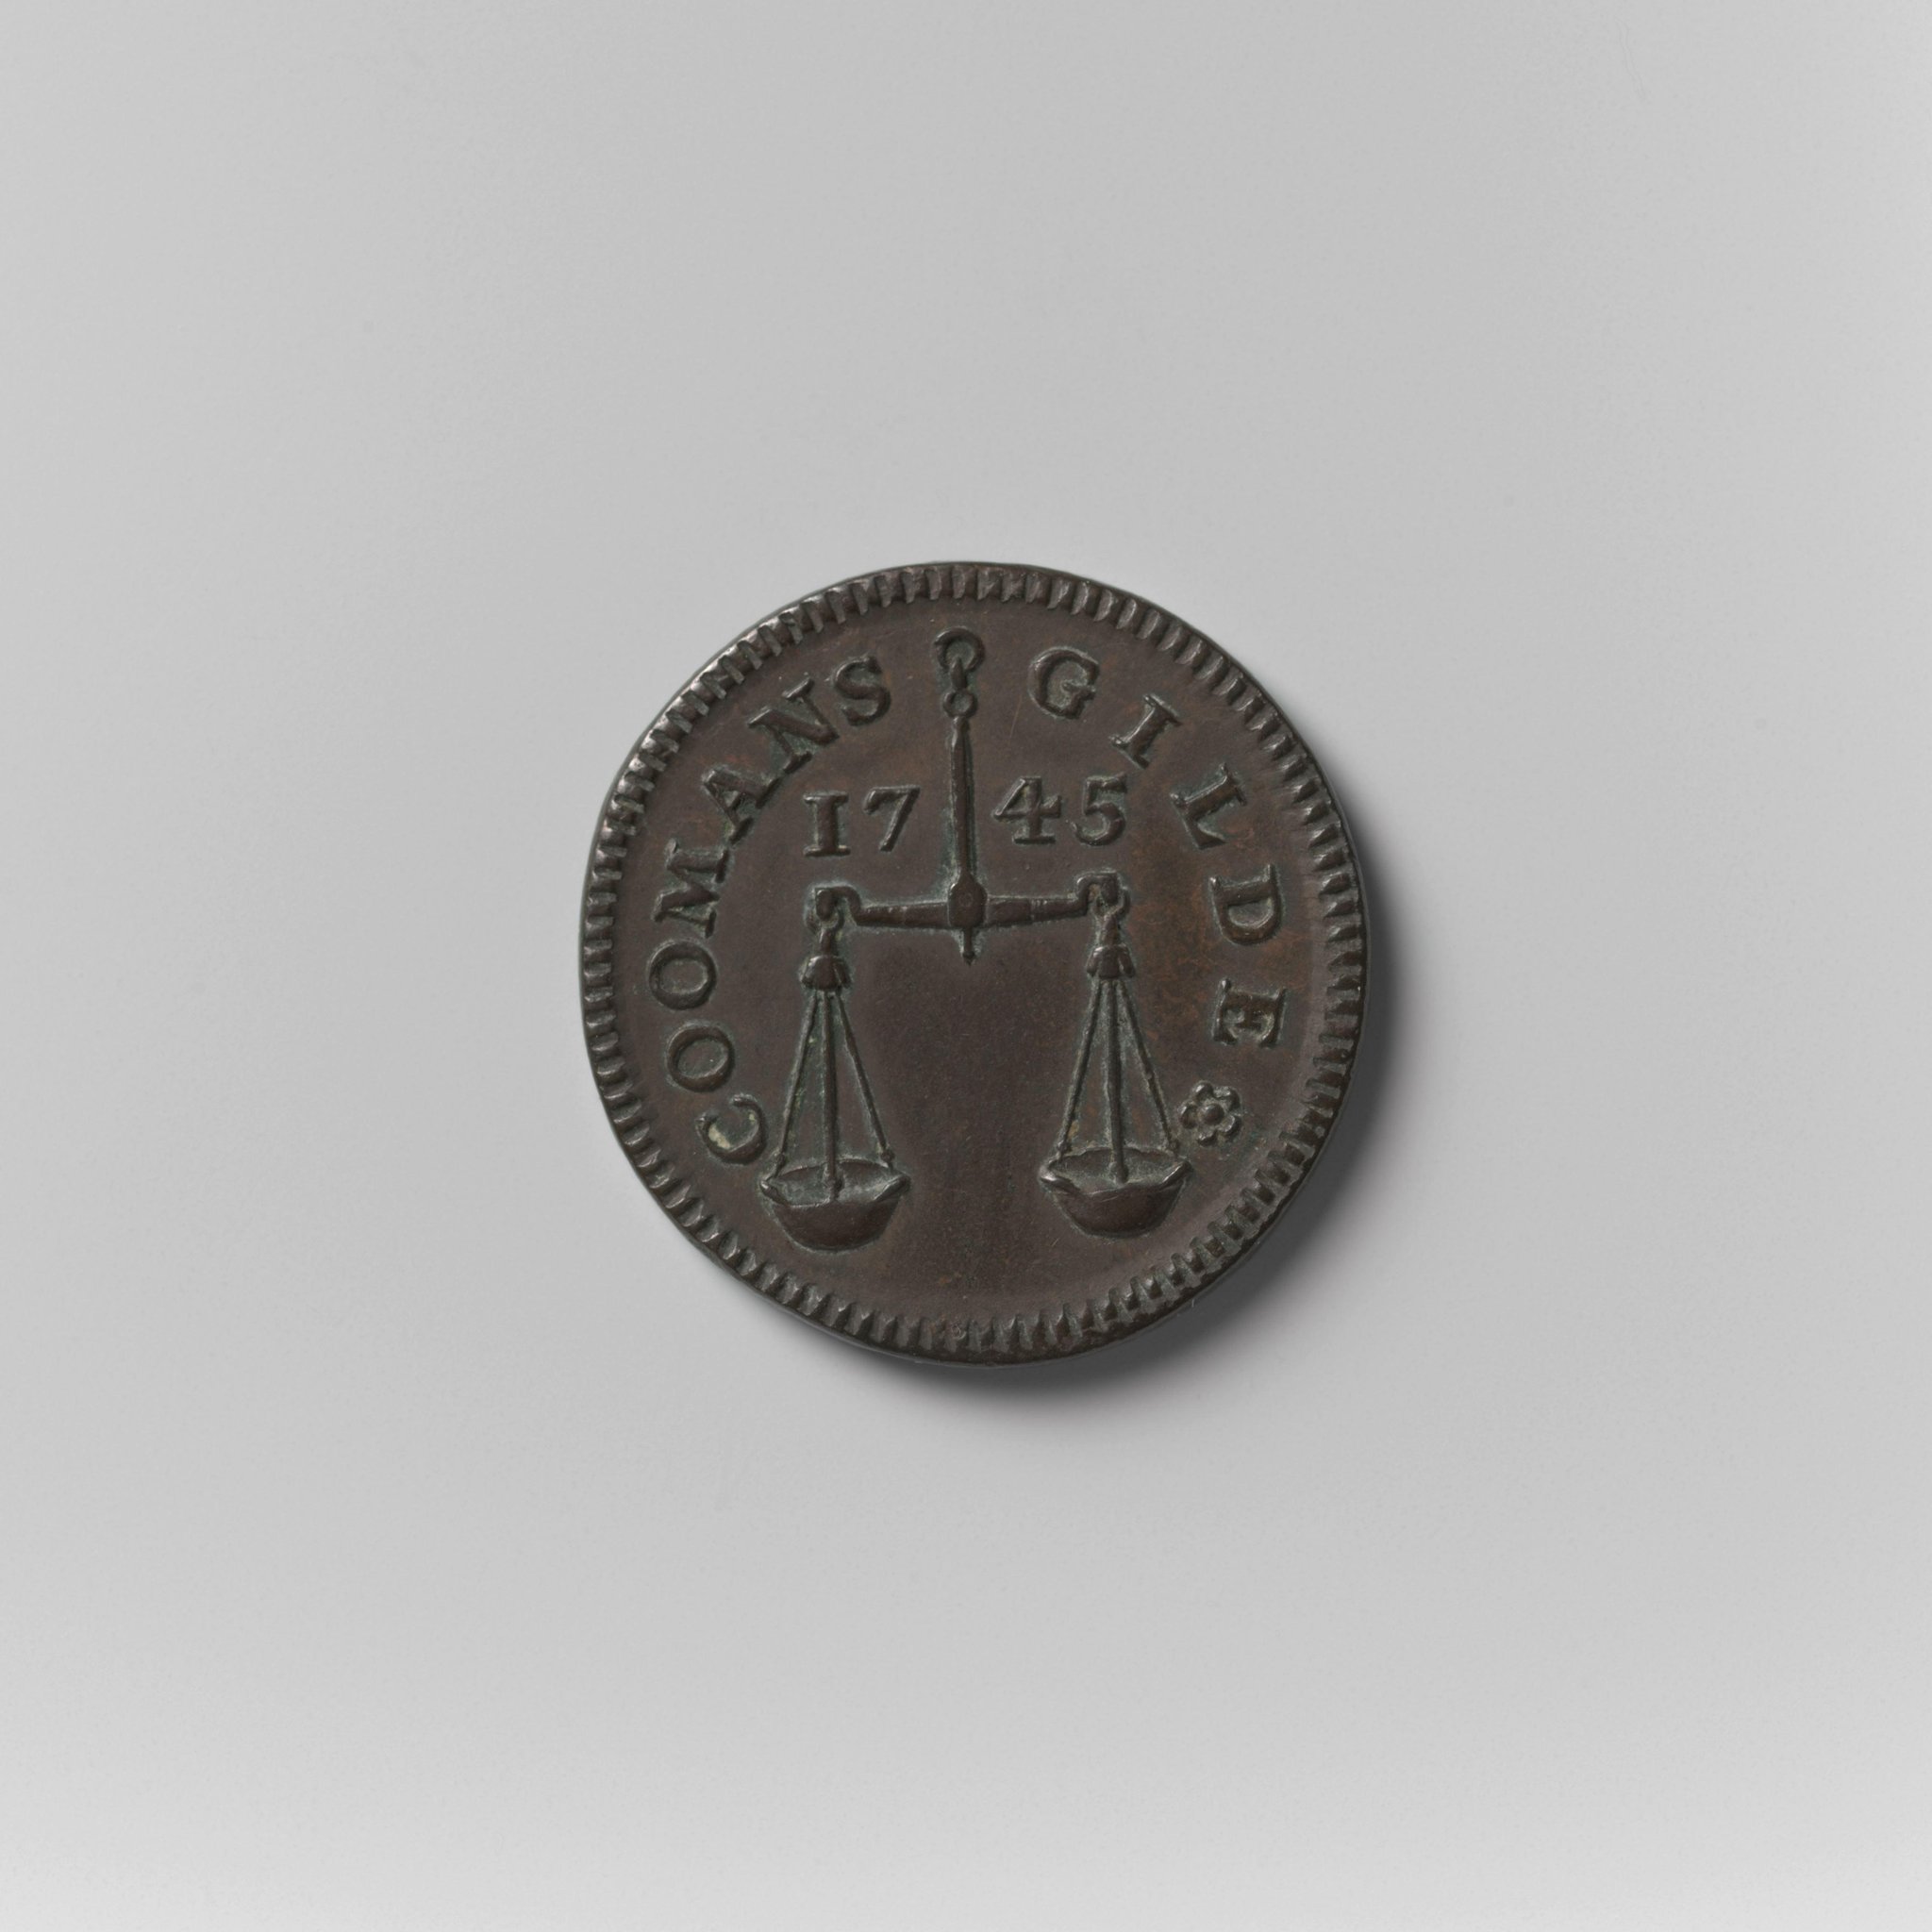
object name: history medal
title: Presentiepenning van het Koopmans- of Kramersgilde te Dordrecht 1745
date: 1745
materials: copper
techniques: striking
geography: dordrecht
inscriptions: circumscription: ‘COOPMANS - GILDE (roos)’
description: Geslagen koperen penning, op de voorzijde een versierd wapenschild Dordrecht, op de keerzijde een balans met het jaartal 1745 en een omschrift